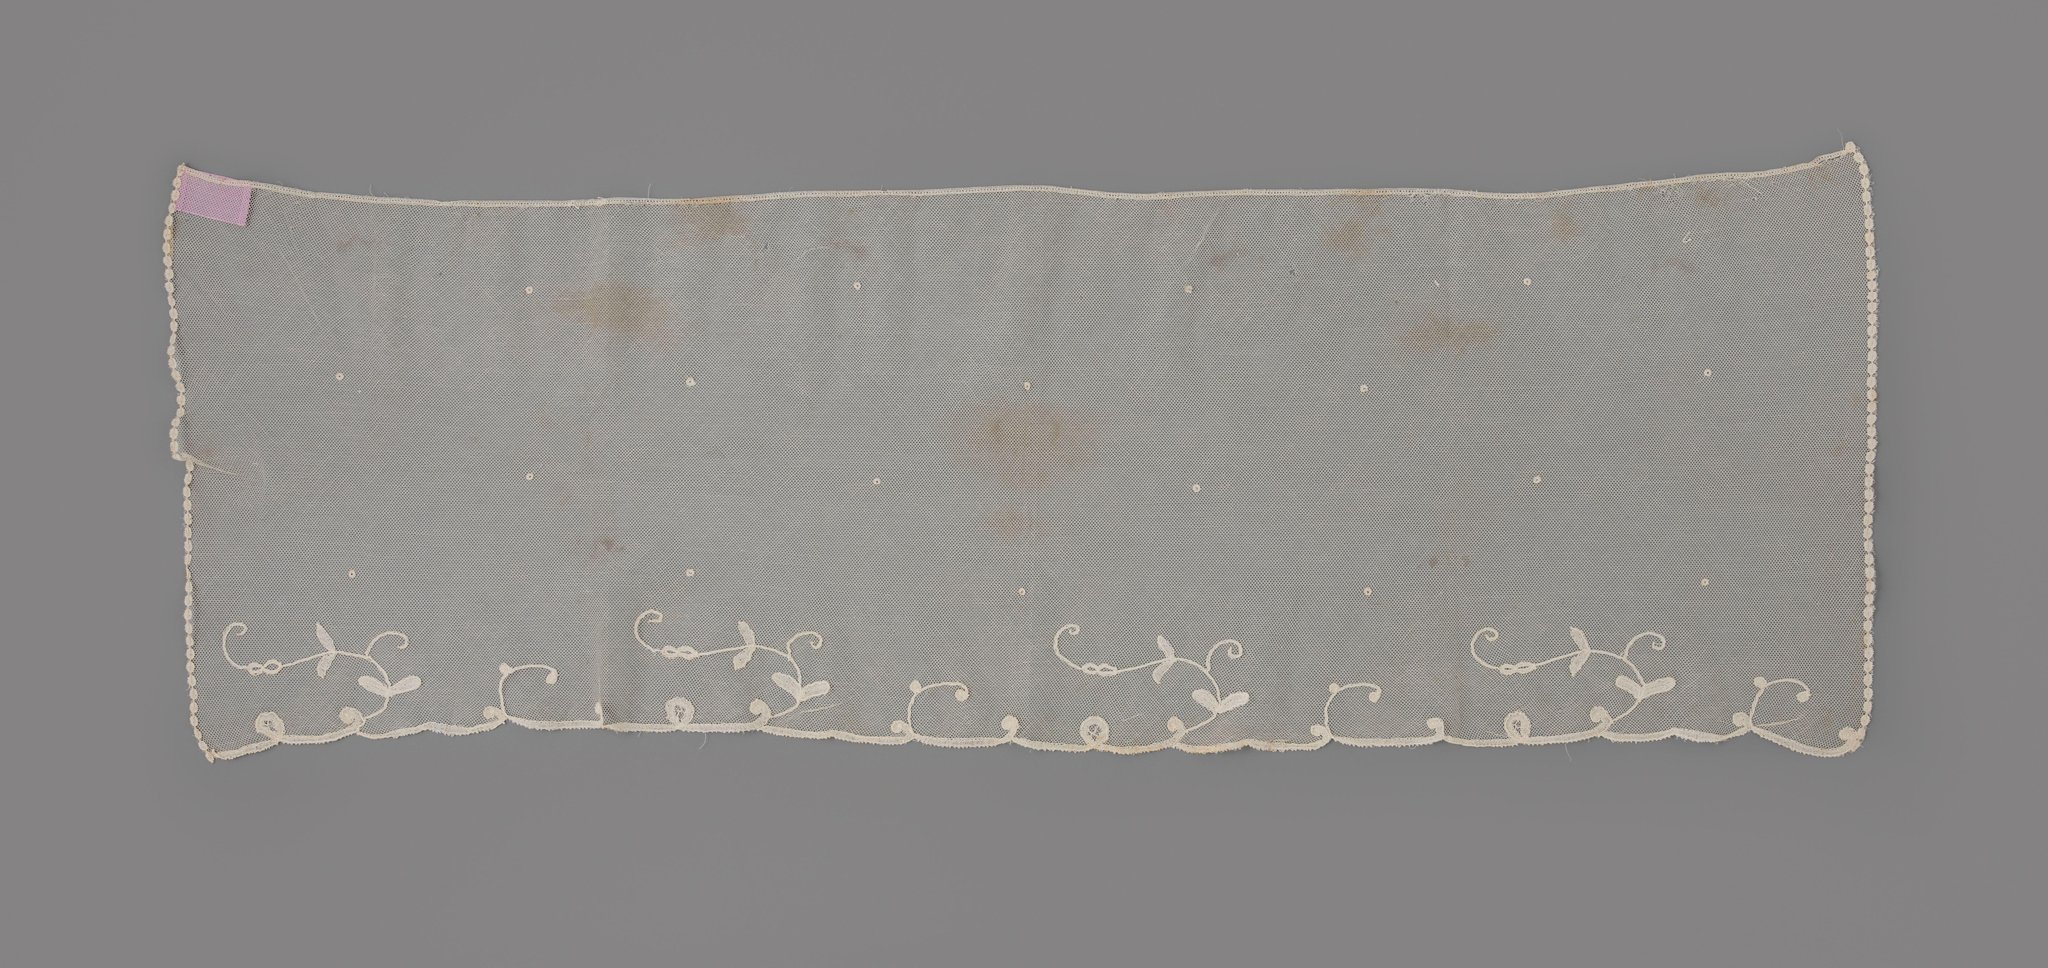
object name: womenswear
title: Hoedensluier van kloskant op tule (applicatiekant)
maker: Anonymous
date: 1900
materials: lace, fiber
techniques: lace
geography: belgium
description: Hoedensluier van applicatiekant. Één van de lange zijden heeft een schulprand waaruit lussen met een siersteek, S-vormige en C-vormige bladtakken komen. De korte kanten zijn afgezet met applicaties in de vorm van een ketting. Moesjes sieren de grond.